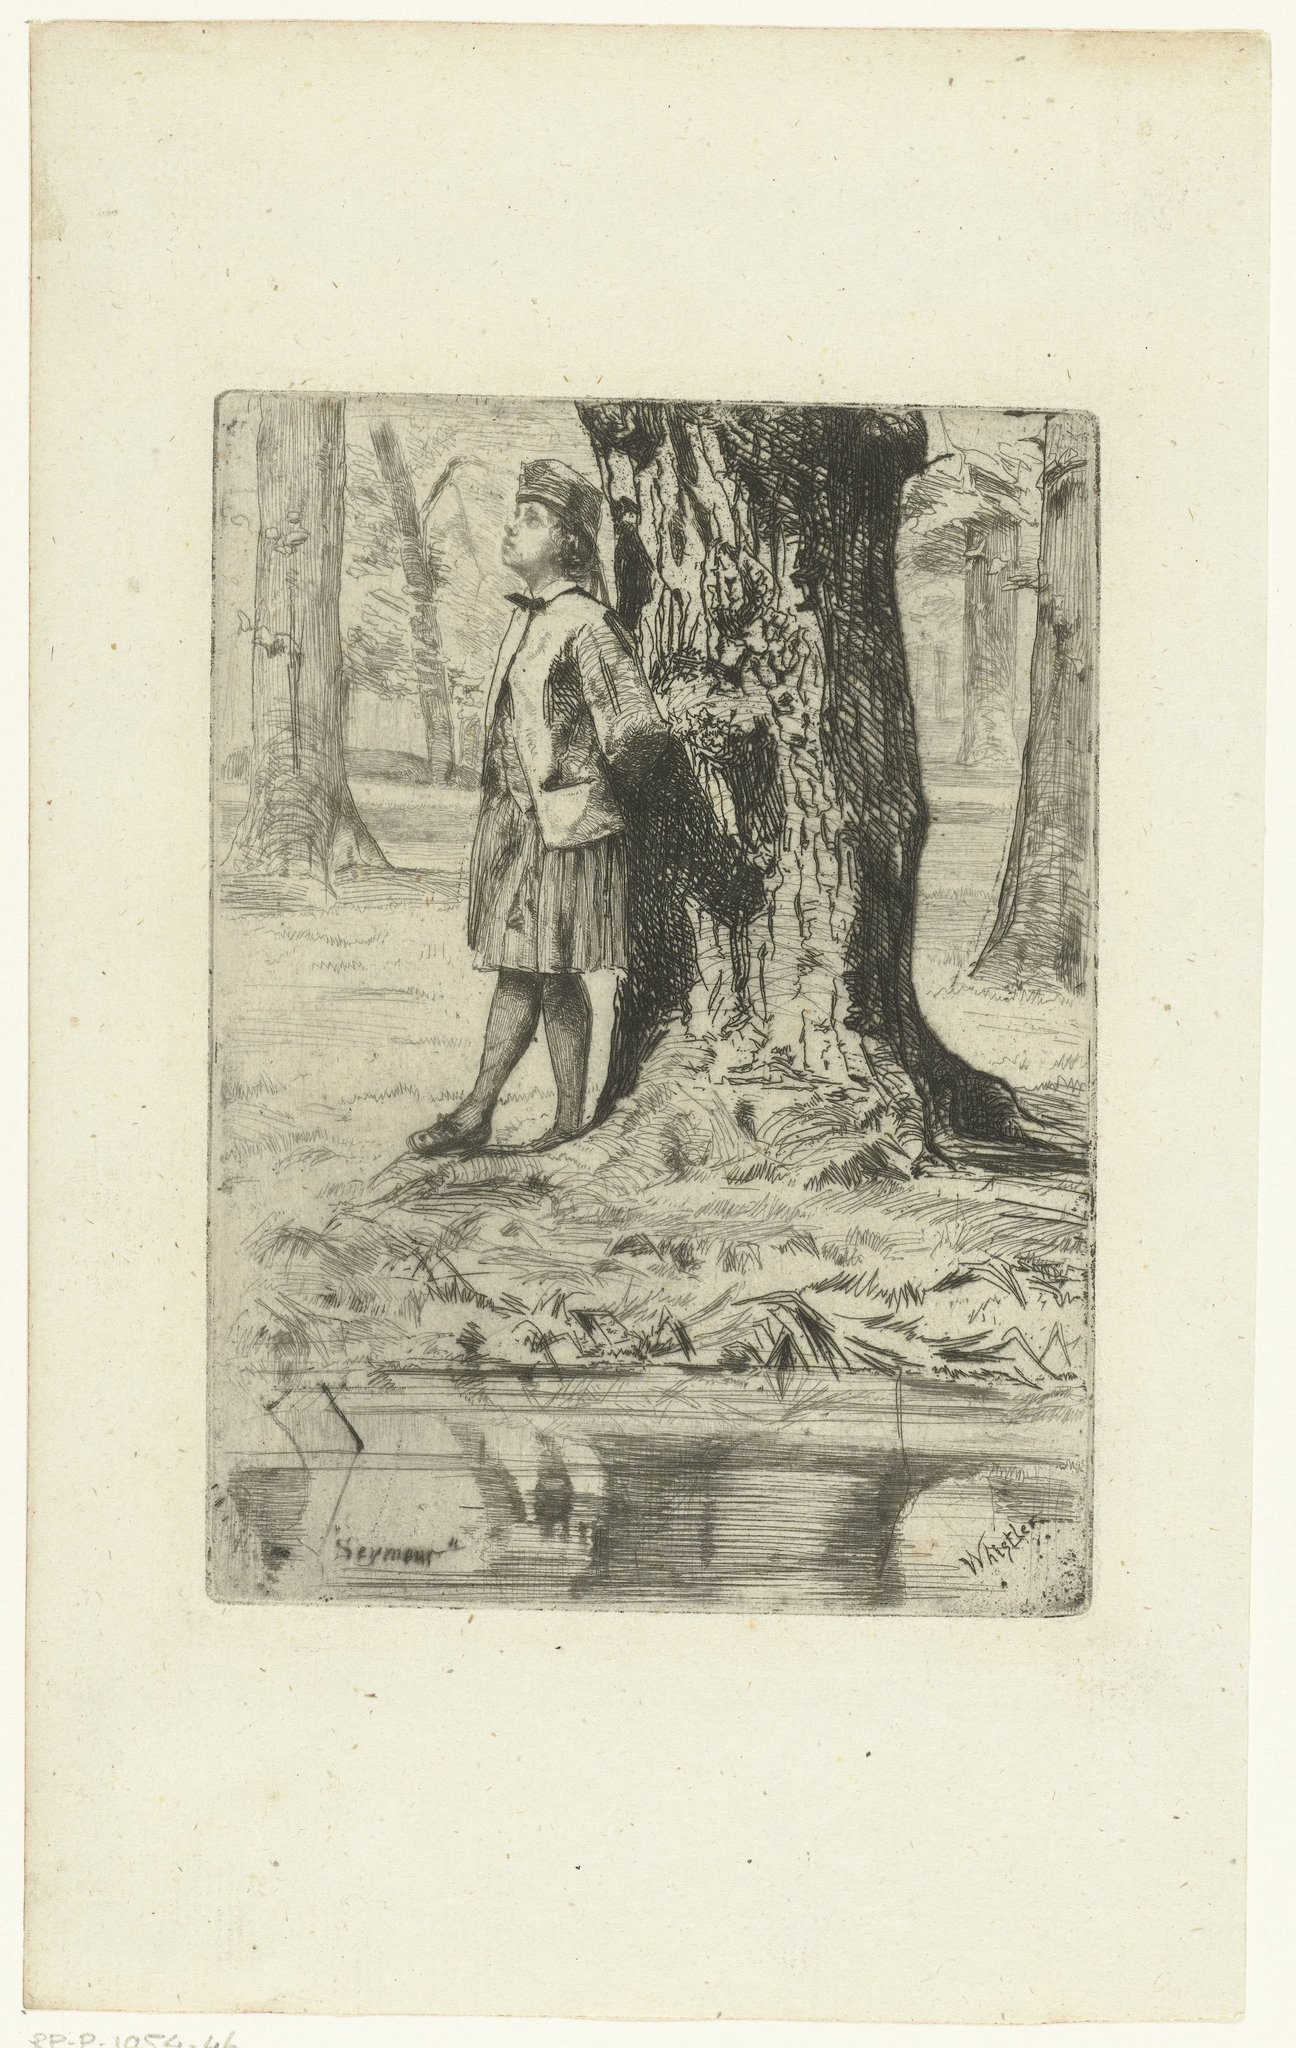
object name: print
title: Seymour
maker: james abbott mcneill whistler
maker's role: painter, print maker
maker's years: 1834-1903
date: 1859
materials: paper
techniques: etching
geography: england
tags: public gardens, park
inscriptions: collector's mark: Lugt 2760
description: De afgebeelde jongen is Seymour Haden, zoon van de kunstenaar Francis Seymour-Haden en het neefje van James Whistler.